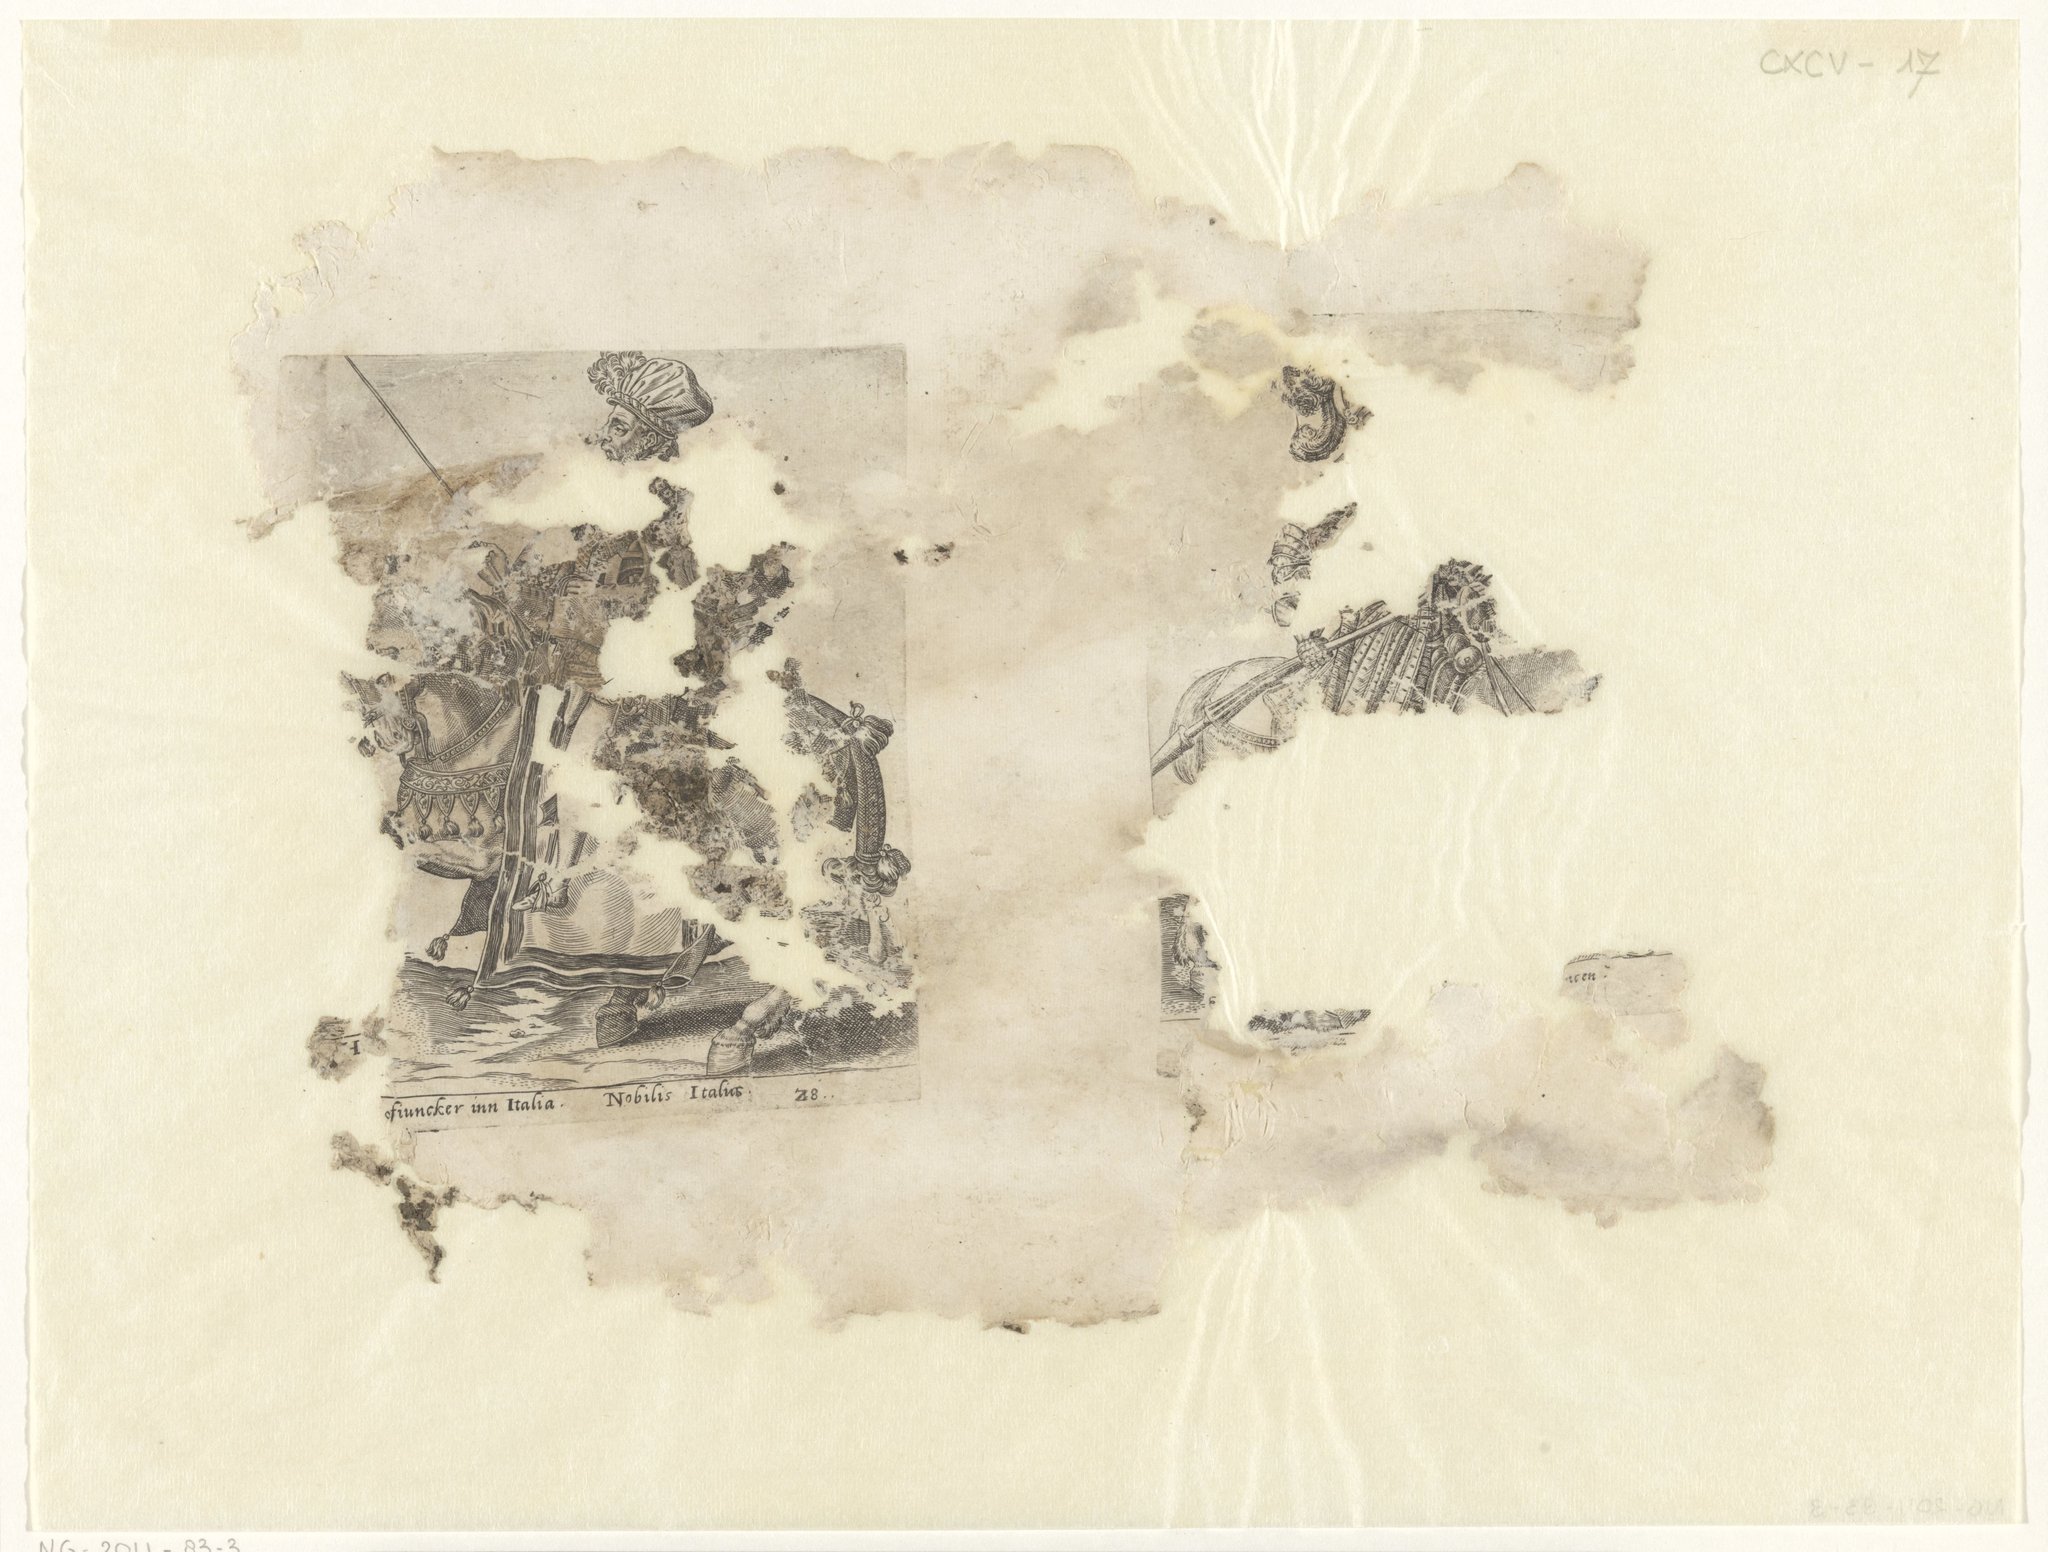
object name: costume print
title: Ruiterserie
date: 1576-1596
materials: paper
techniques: engraving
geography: cologne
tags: warfare; military affairs (+ cavalry, horsemen), folk costume, regional costume, military clothing and other equipment (uniforms, cap, armour, helmet, etc.)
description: Prent 28 en 29 uit een serie van 77, mogelijke serietitel Diversarum gentium armatura Equestris. Latere editie van serie Equitum Descripcio, Quomodo Equestres (...). De prenten in de Nova Zembla collectie zijn tijdens een expeditie van Willem Barendsz en Jacob van Heemskerk in 1596-1597 noodgedwongen in het winterkamp, het ‘Behouden Huis’, op het eiland achtergelaten. De prenten waren in één of meerdere stapels als handelswaar meegenomen vanuit Amsterdam. Bijna drie eeuwen later, in 1871, keerde de Noor Elling Carlsen terug naar Nova Zembla en vond daar de restanten van het ‘Behouden Huis, inclusief een groot deel van de inventaris. Een deel van de prenten, in de vorm van aaneengekoekte kluiten, werd toen ook teruggevonden. De papierkluiten waren soms op meerdere plekken gebroken. Tussen 1975-1979 zijn de prenten van elkaar gescheiden. Dit leverde in totaal ca. 1000 fragmenten van ca. 400 afdrukken van ca. 150 verschillende prenten op. Voor zover mogelijk zijn de fragmenten samengevoegd en zijn de prenten gereconstrueerd.